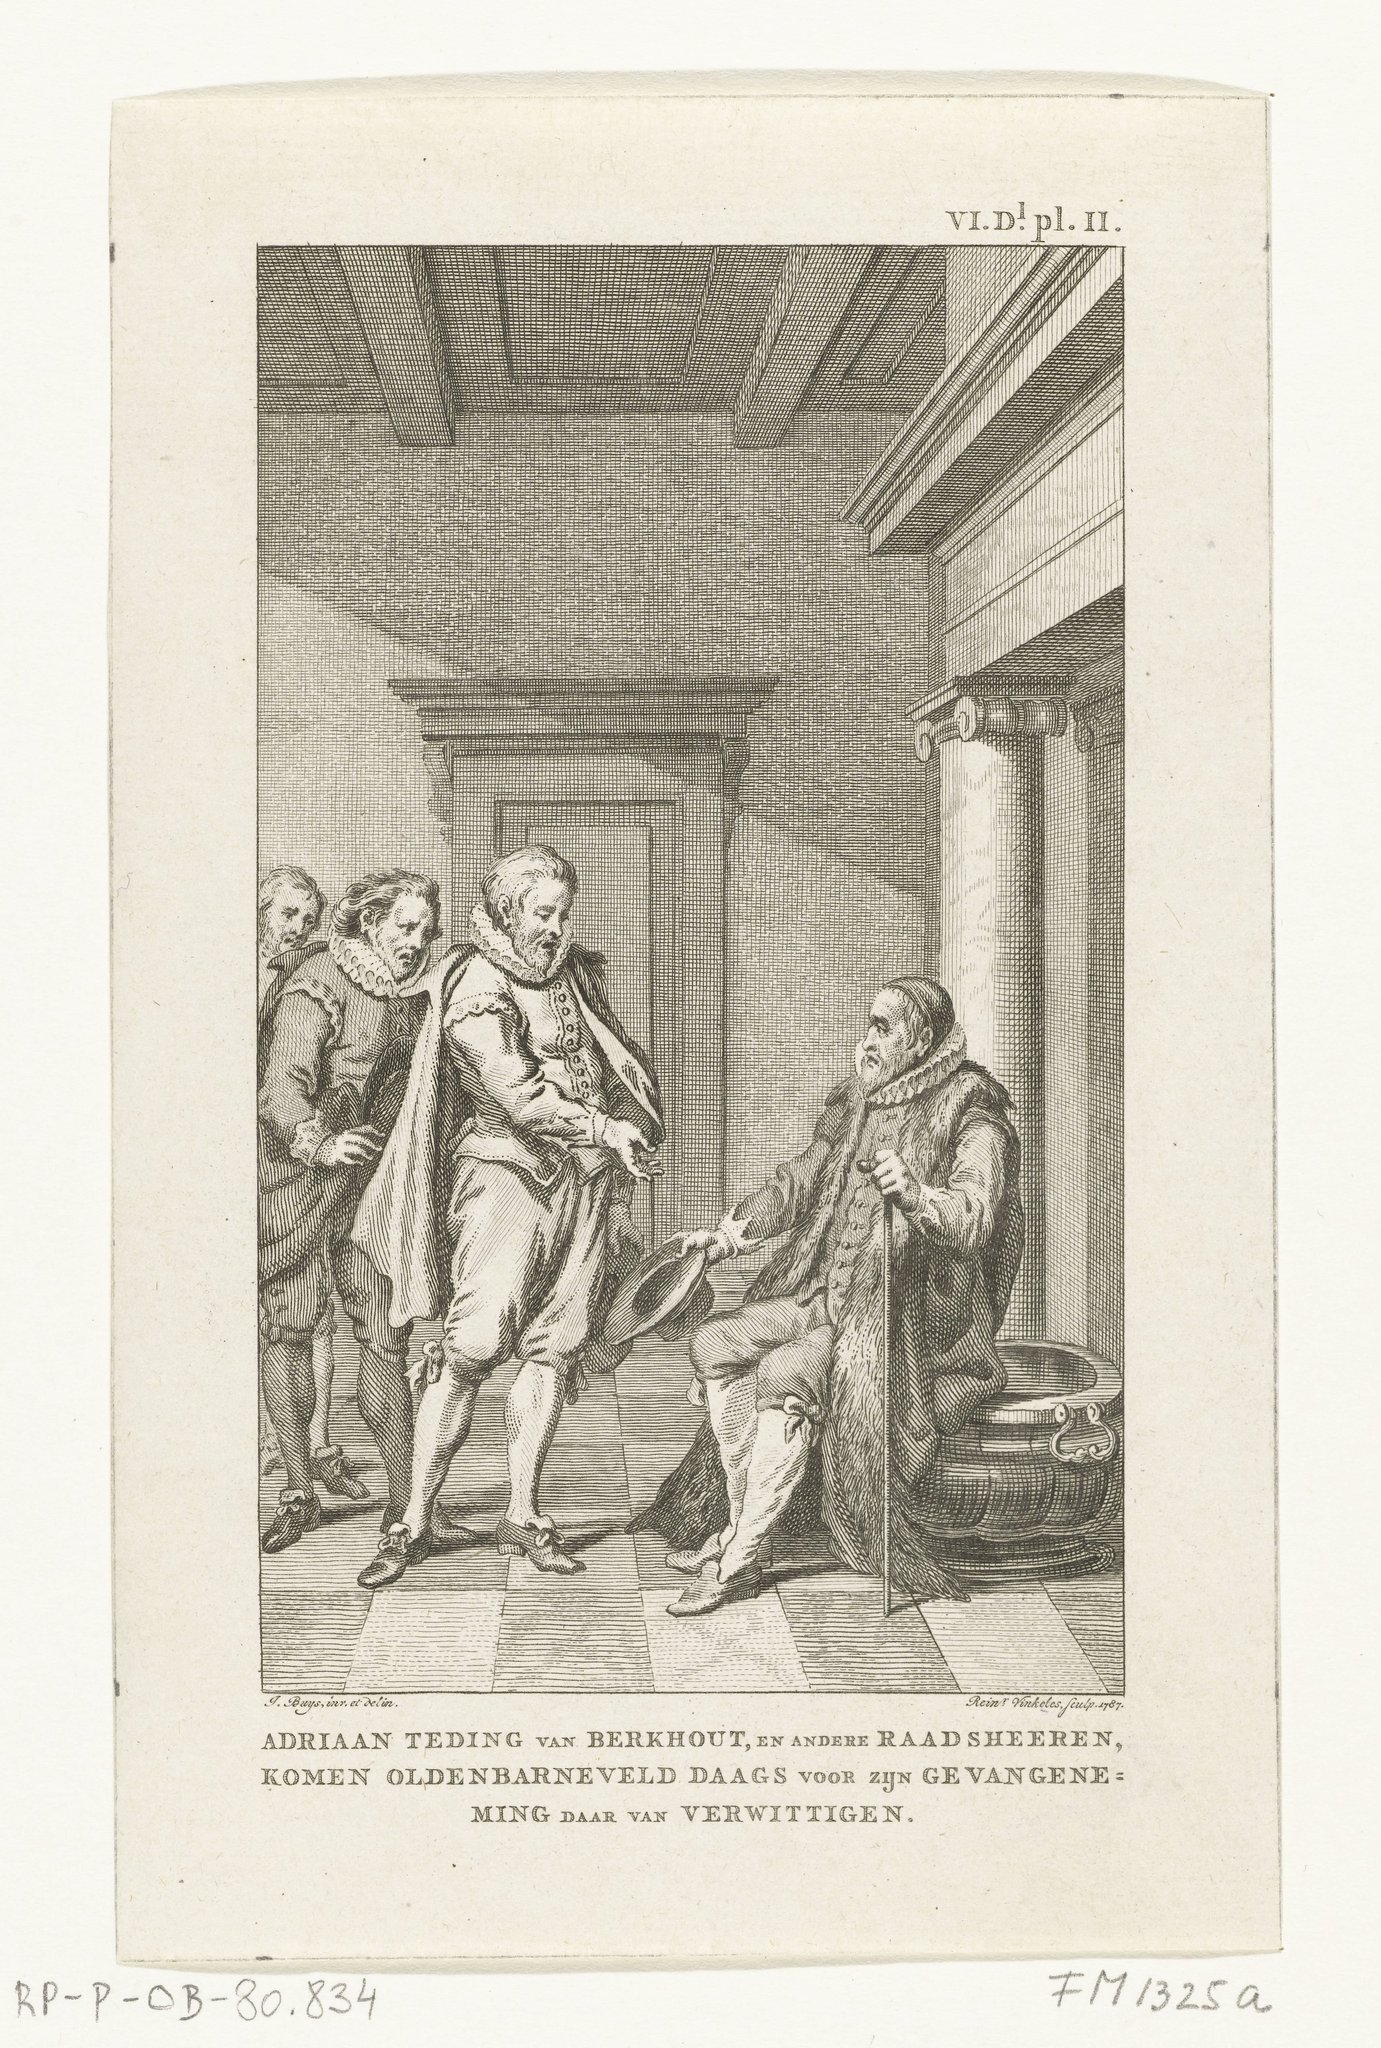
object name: print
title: Raadsheer Teding van Berkhout waarschuwt Johan van Oldenbarnevelt dat men hem gevangen zal nemen, 1618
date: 1787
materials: paper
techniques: etching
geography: northern netherlands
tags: johan van oldenbarnevelt, hoorn (north holland)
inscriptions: date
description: Raadsheer Adriaan Teding van Berkhout waarschuwt Johan van Oldenbarnevelt dat men hem gevangen zal nemen, 28 augustus 1618. De raadspensionaris zittend op een groot bekken.